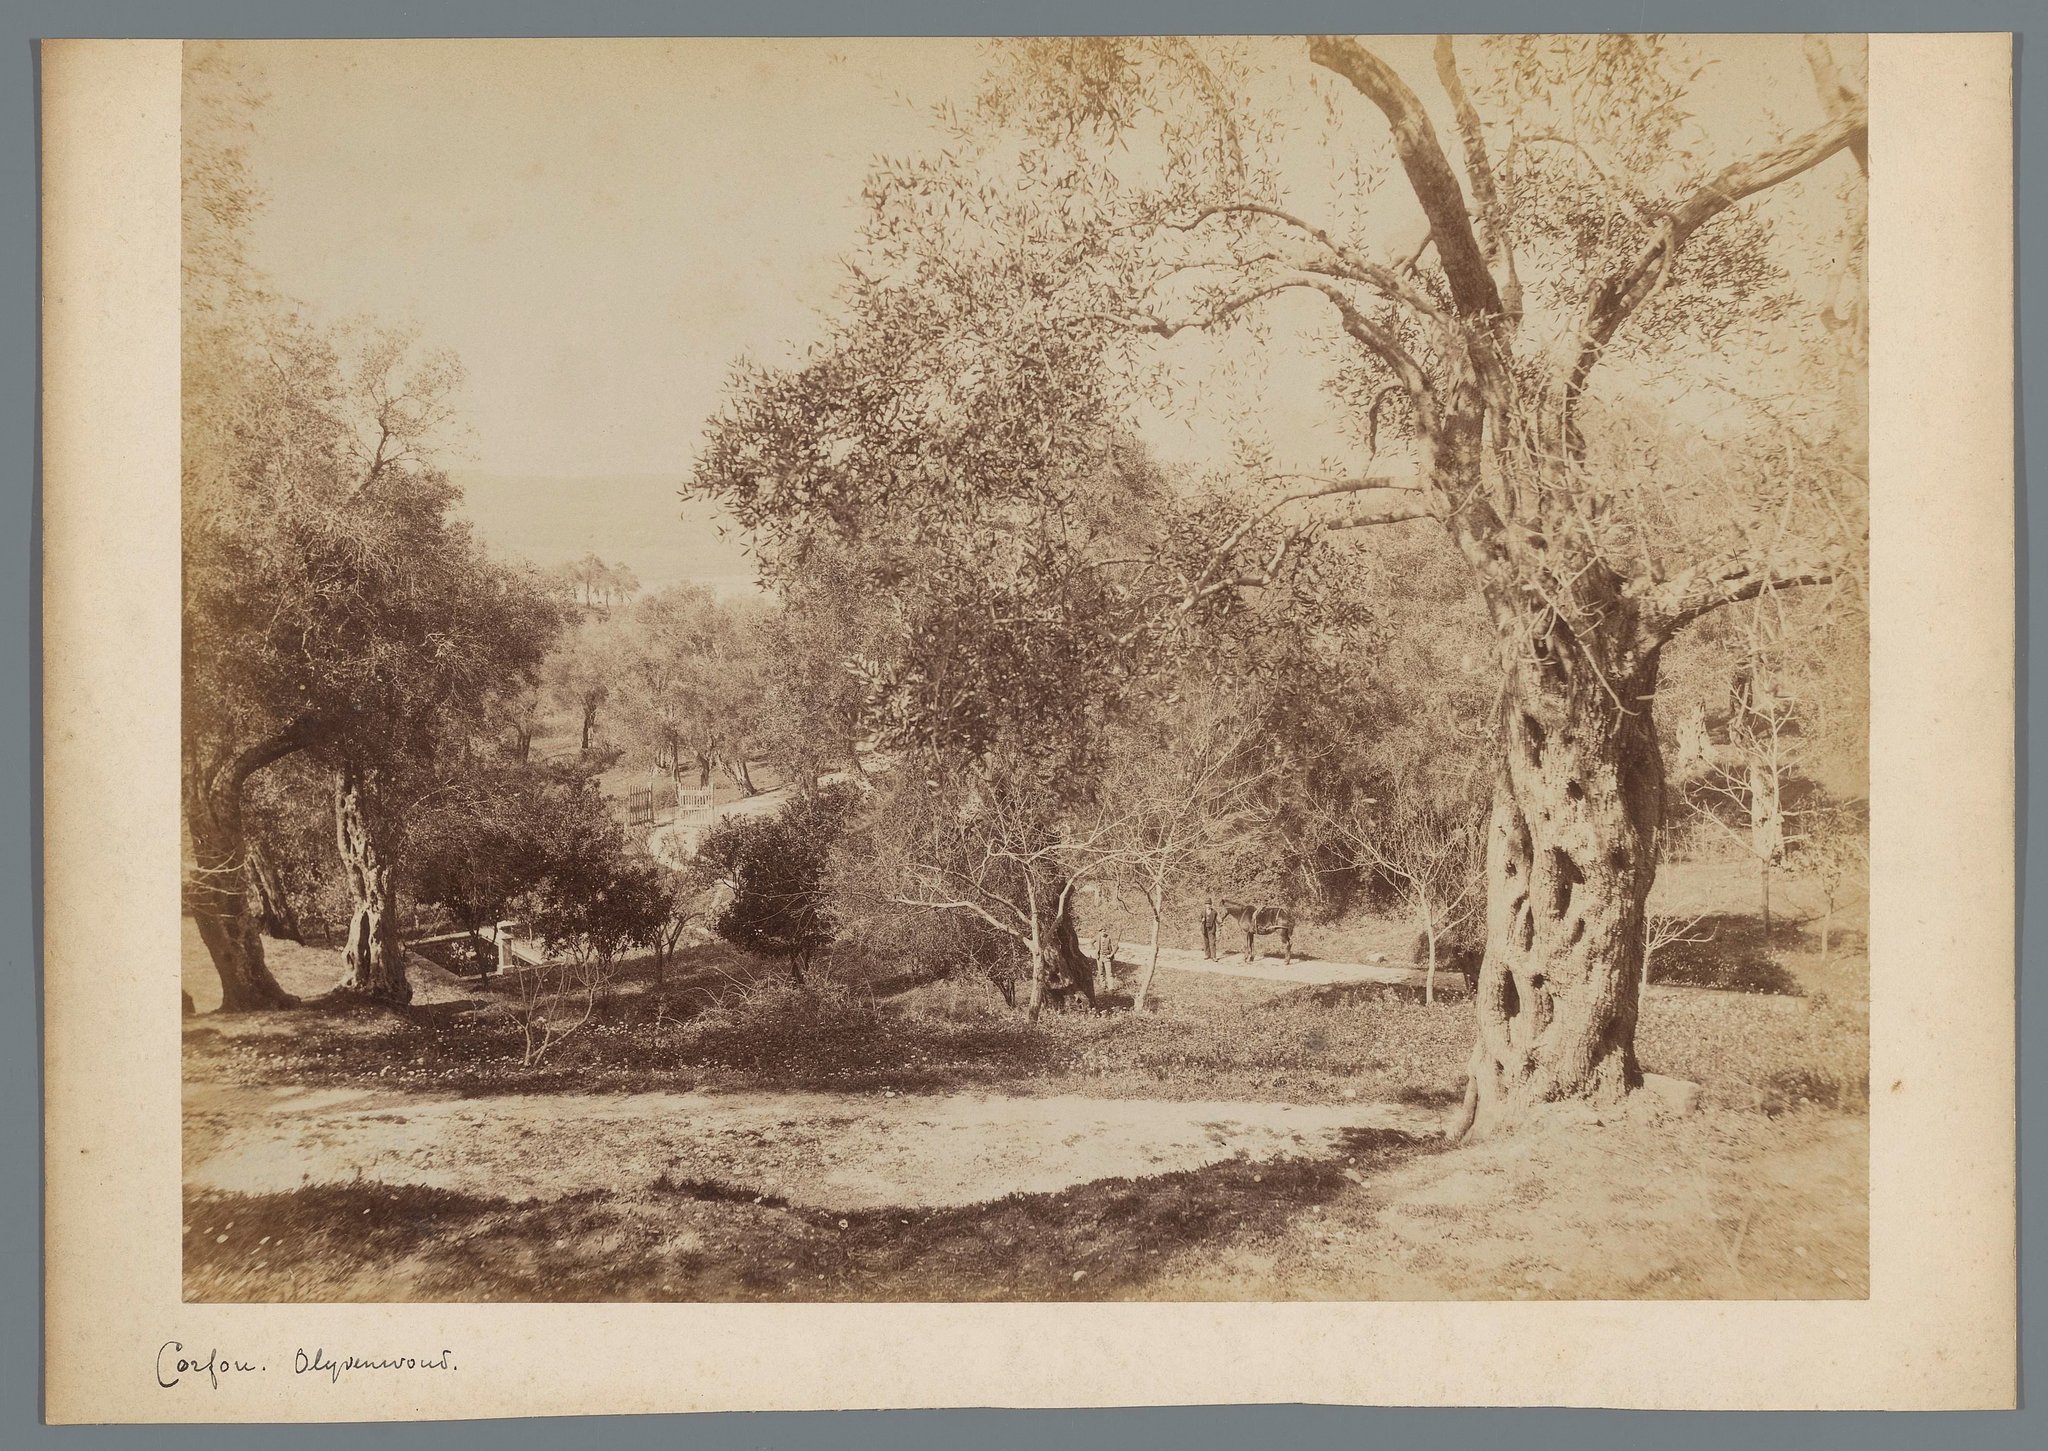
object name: photograph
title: Corfou, olijvenwoud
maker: Anonymous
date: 1860-1900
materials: cardboard, paper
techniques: albumen print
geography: corfu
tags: trees: olive-tree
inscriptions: number: ‘1903’